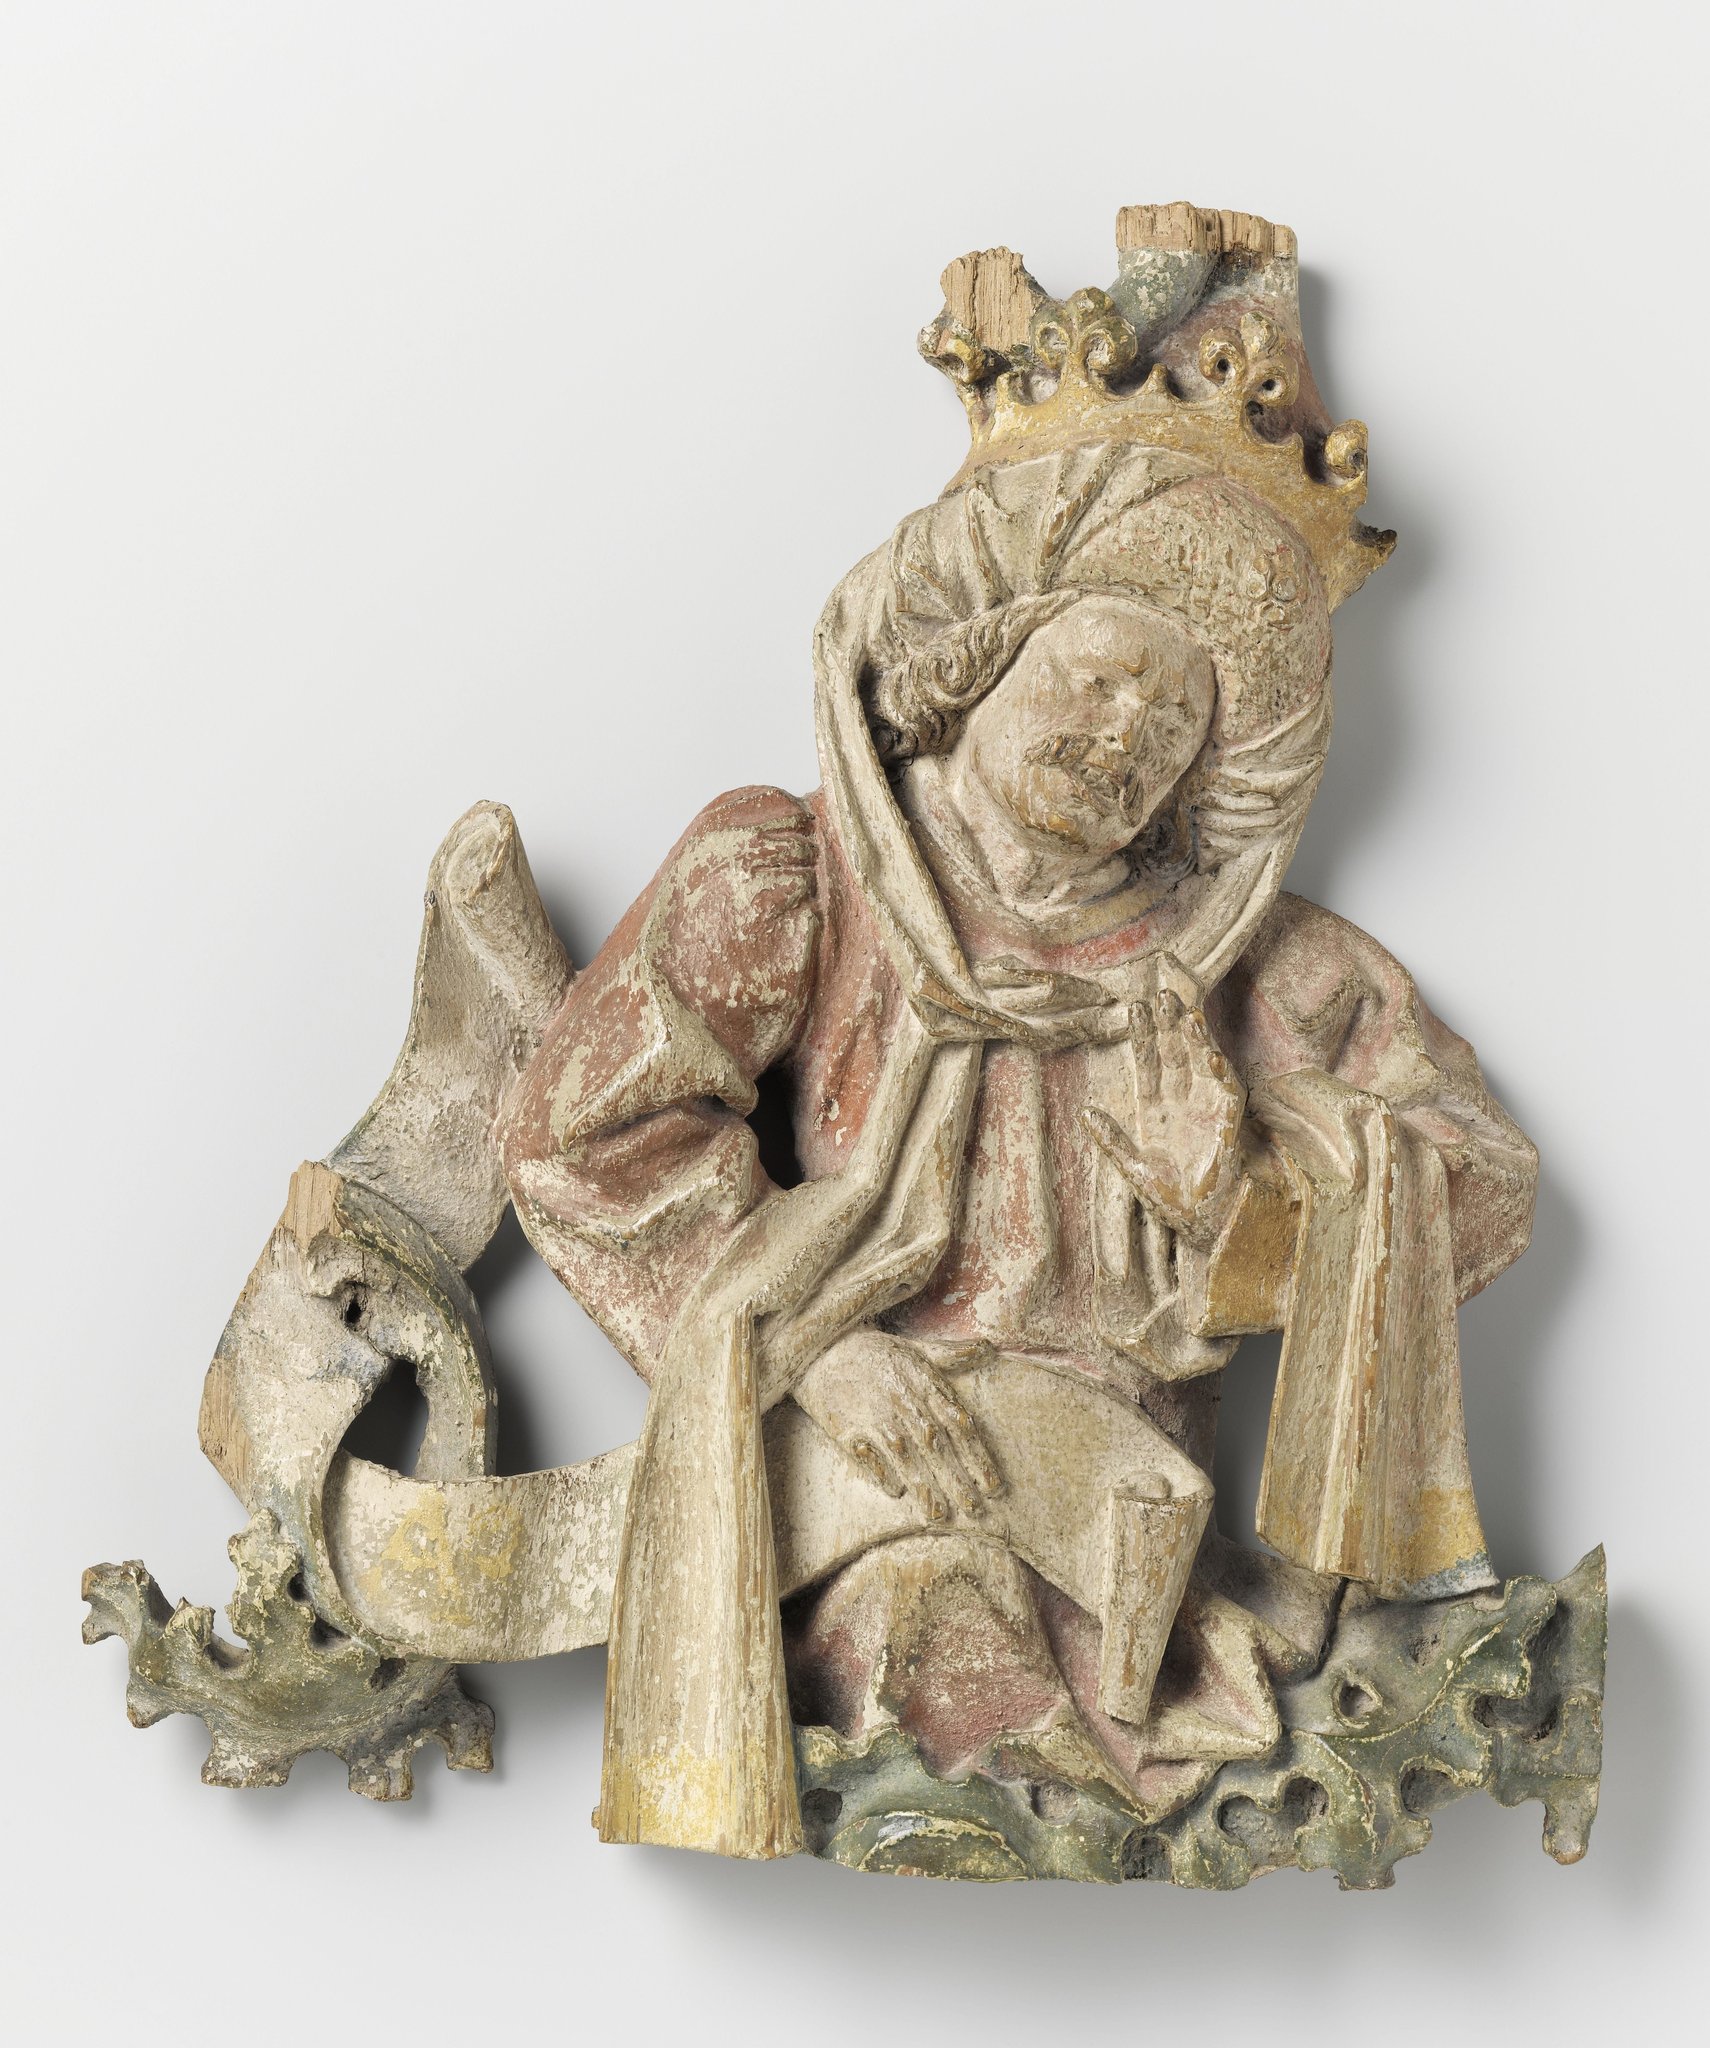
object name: sculpture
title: King, from a Tree of Jesse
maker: master arnt of kalkar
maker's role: sculptor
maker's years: -1492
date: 1470-1480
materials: wood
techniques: polychromy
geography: kalkar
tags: tree of jesse: genealogical tree showing christ's ancestors, sprouting from jesse's loins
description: Arnt van Kalkar (active c. 1460 - 1492). King, fragment from a Tree of Jesse. Oak with remains of polychromy. Antwerp, c. 1500 - 1525.